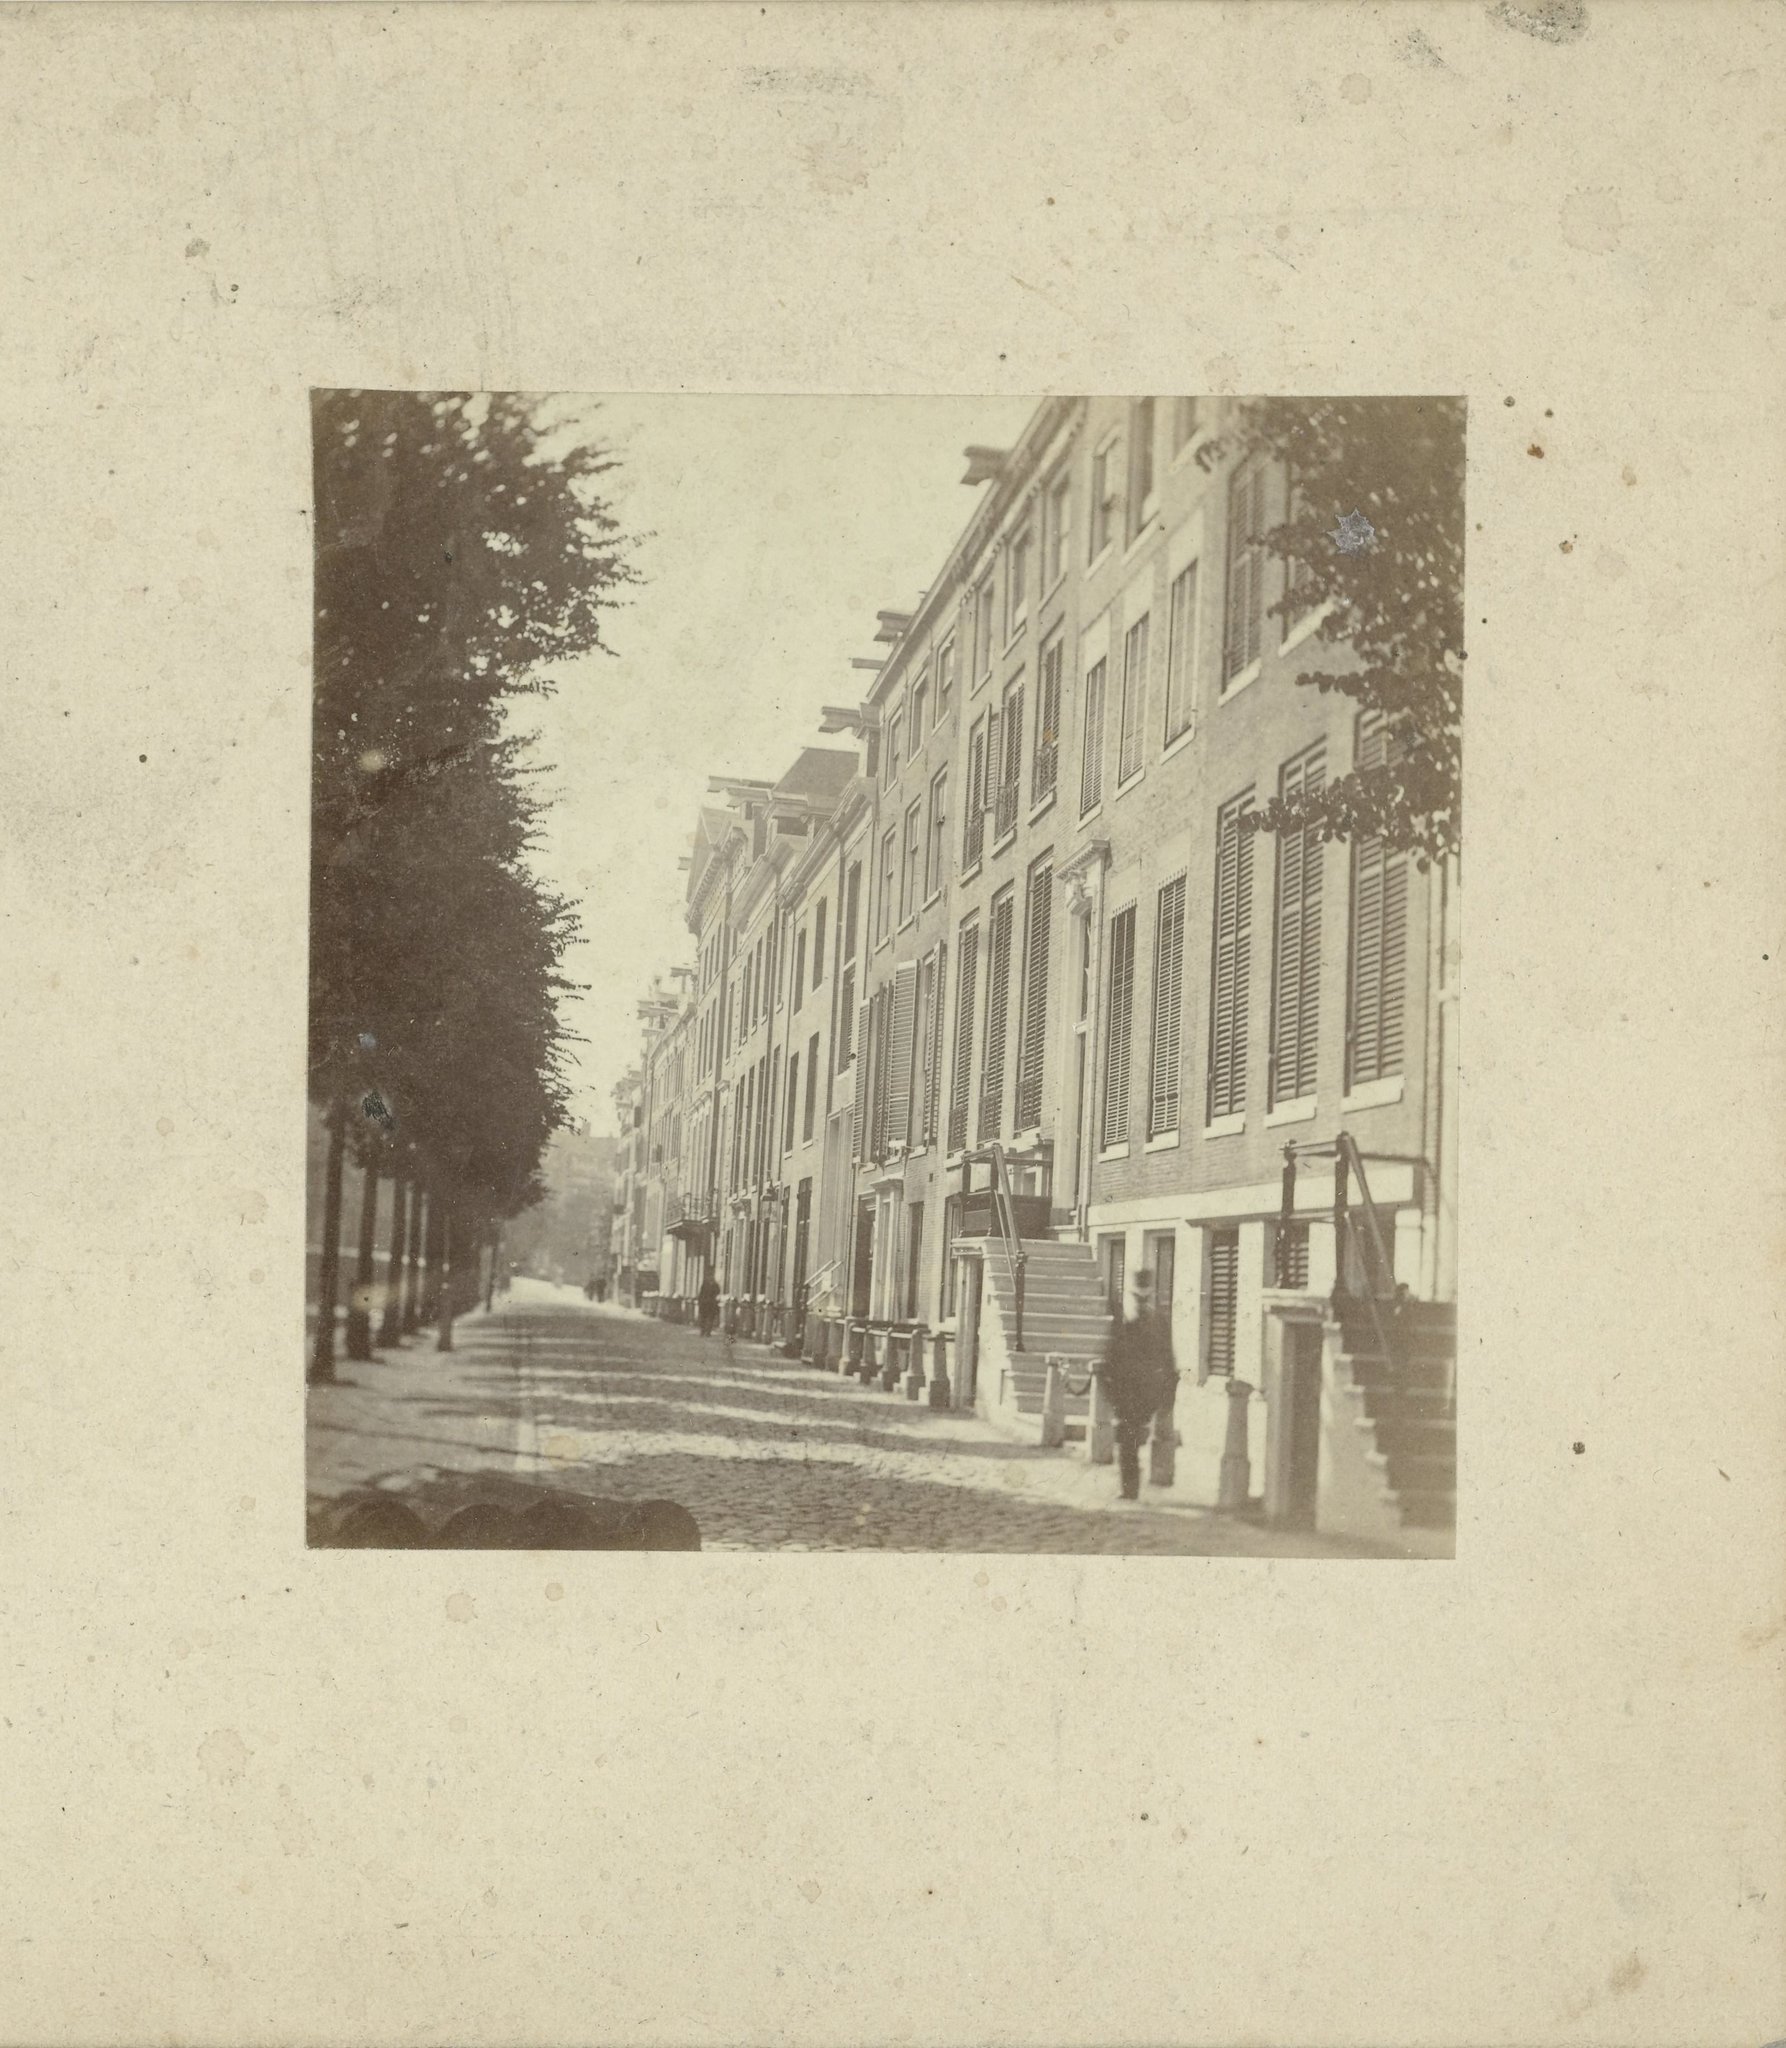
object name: photograph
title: Keizersgracht in Amsterdam, in de richting van de Nieuwe Spiegelstraat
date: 1860-1875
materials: cardboard, paper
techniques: albumen print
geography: amsterdam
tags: street